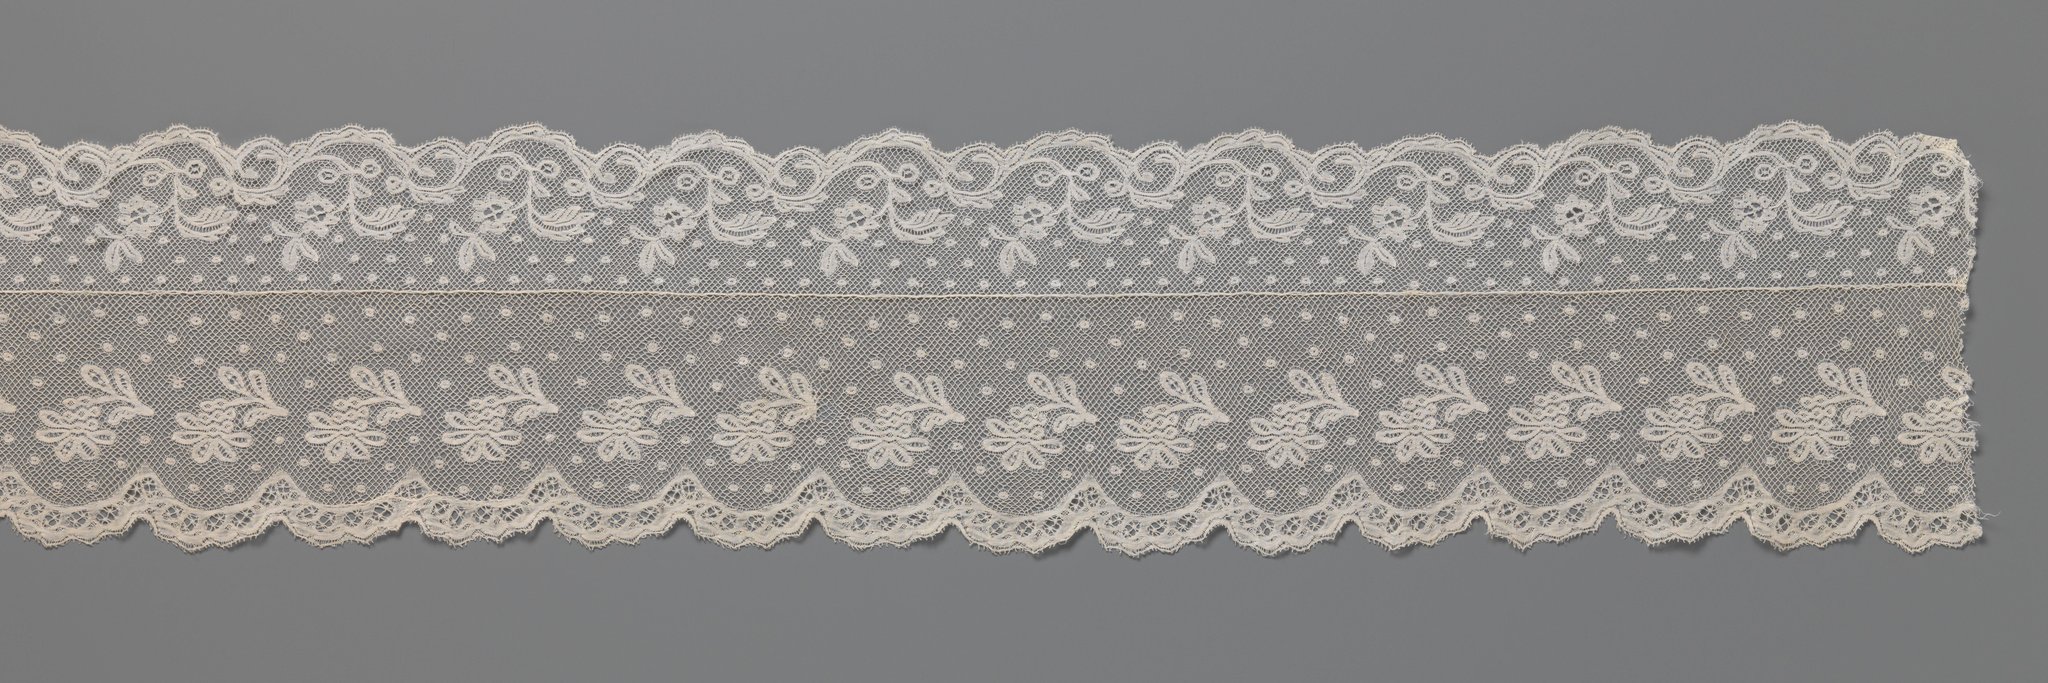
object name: strip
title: Strook kloskant met kromme takjes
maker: Anonymous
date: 1875-1899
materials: linen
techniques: lace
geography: sluis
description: Op een grof en met moesjes bezaaid mazenfond (vierkante maas) staat, boven een halfcirkelvormige schulp, een open patroon van een overhangend takje met een bloem. Valenciennes-kant. Oorspronkelijk was deze strook één van de delen van een strook die uit vier losse delen bestond. Hiervan zijn er echter drie aan elkaar genaaid: BK-BR-J-259-A, -B, -C. In 1966 is aan deze bovenzijde van de lange strook die zo is ontstaan, vervolgens een iets smallere strook gezet, BK-BR-J-321-A, met een enigszins vergelijkbaar patroon.